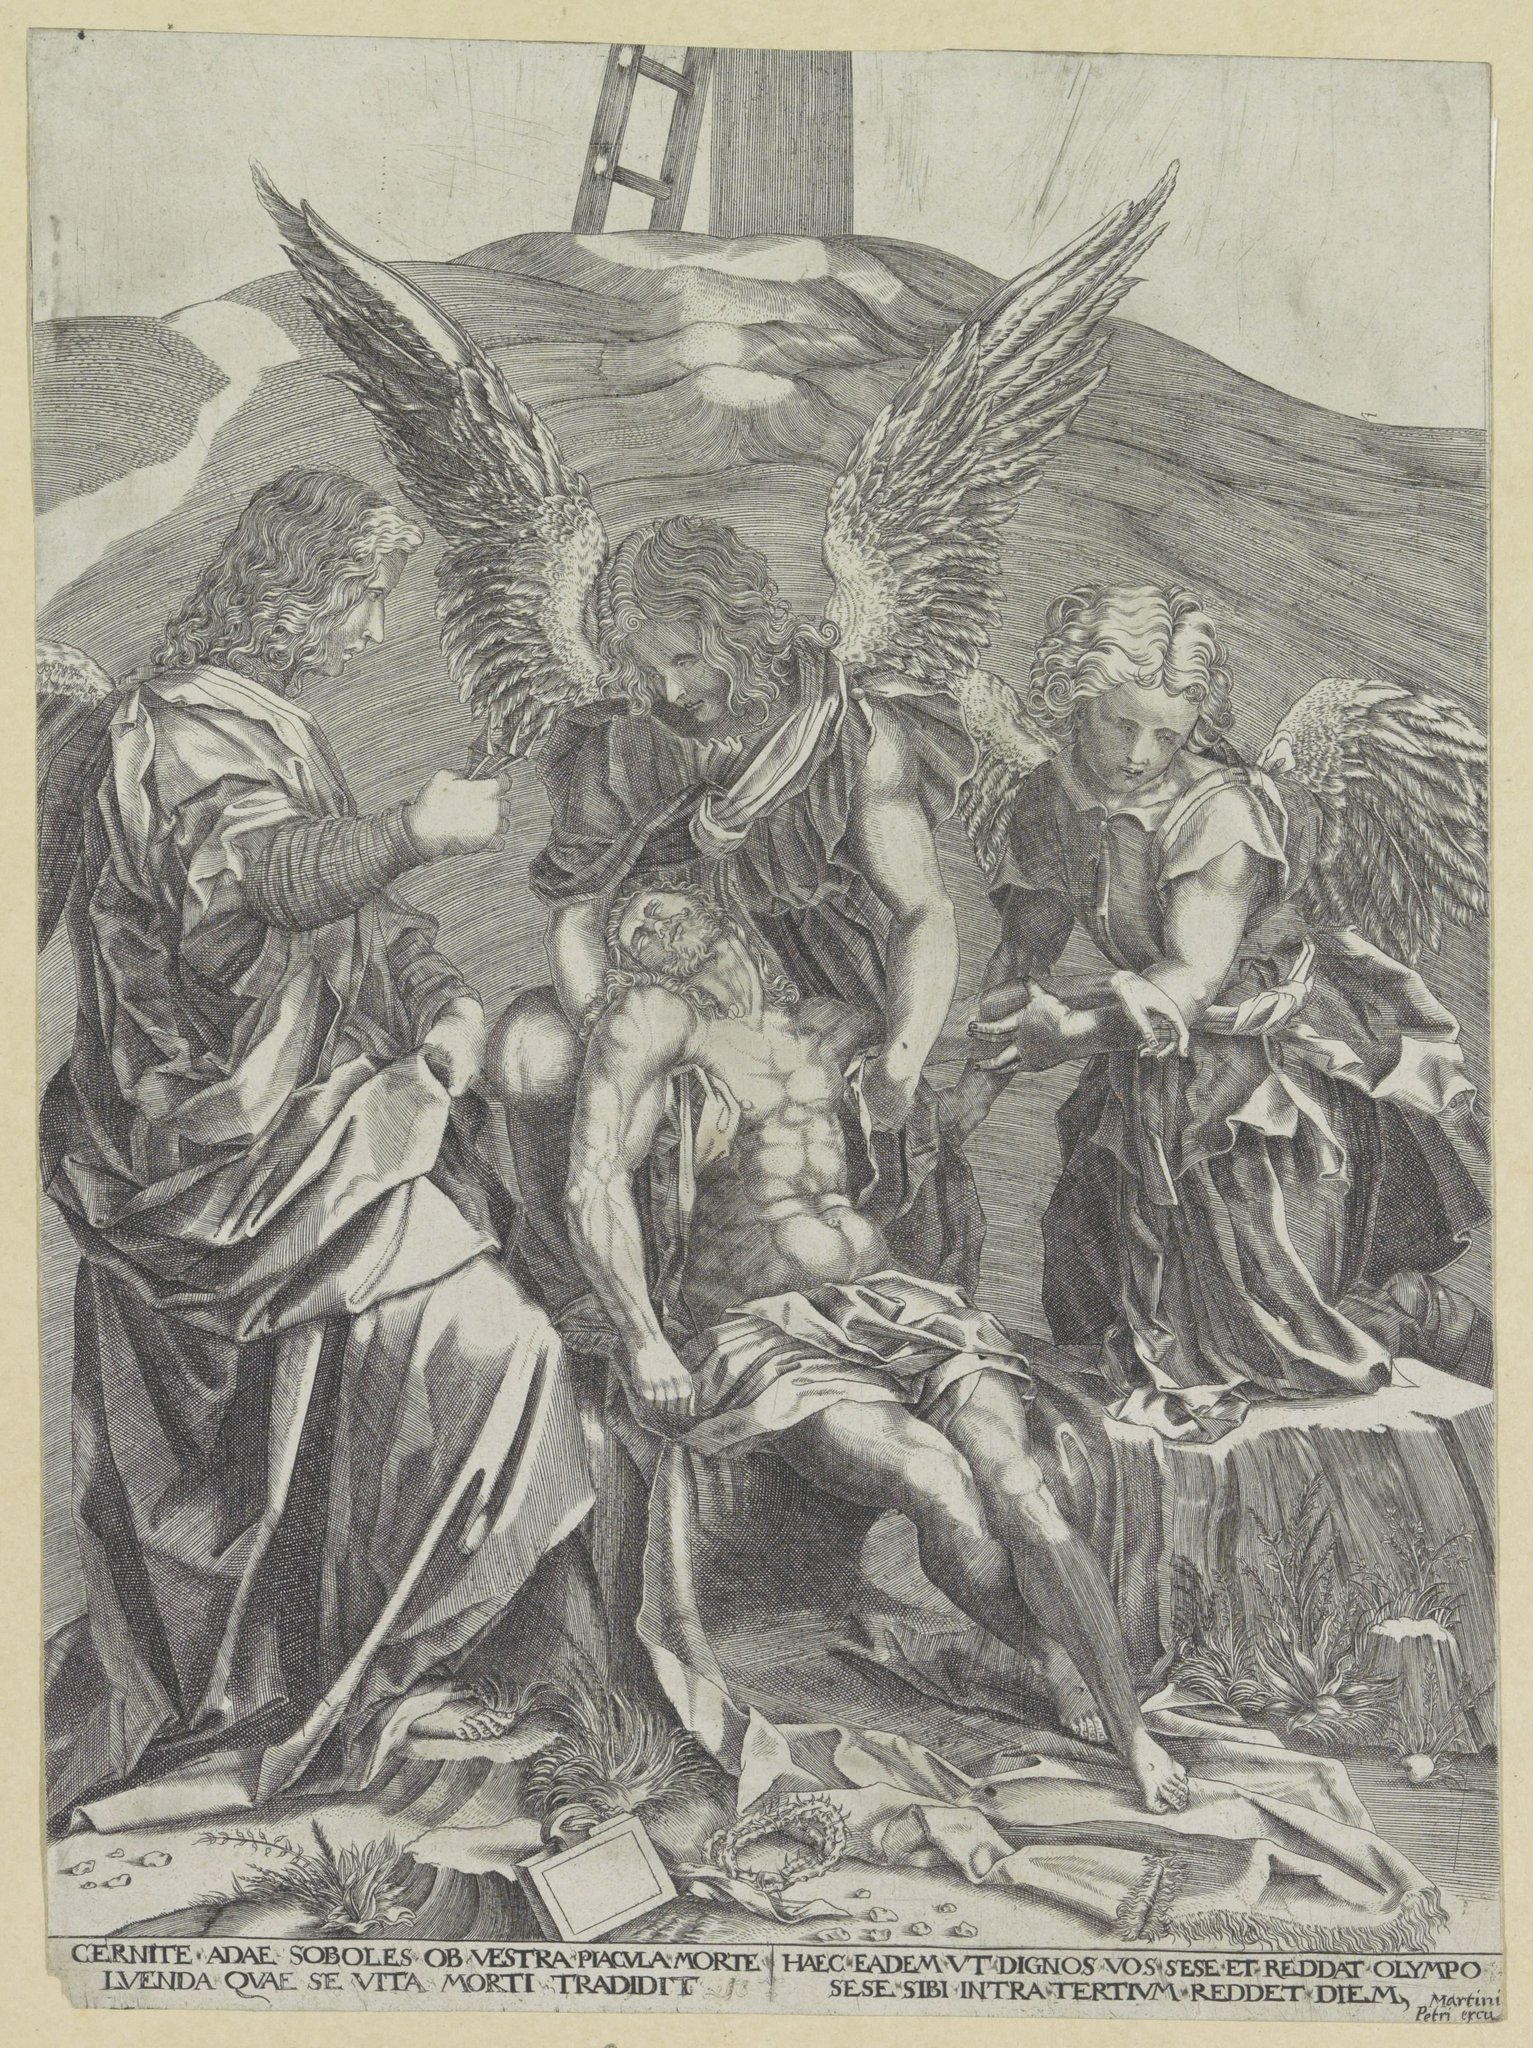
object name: print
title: Bewening van Christus door drie engelen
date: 1510-1570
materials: paper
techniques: engraving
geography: italy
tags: lamentation over the dead christ by his relatives and friends (christ usually without crown of thorns)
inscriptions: collector's mark, collector's mark: Lugt 2228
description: Een engel ondersteunt Christus' lichaam, twee andere engelen staan naast hen. Op de achtergrond de onderkant van het kruis. Op de voorgrond de doornenkroon. In de ondermarge een Latijnse tekst in twee kolommen.